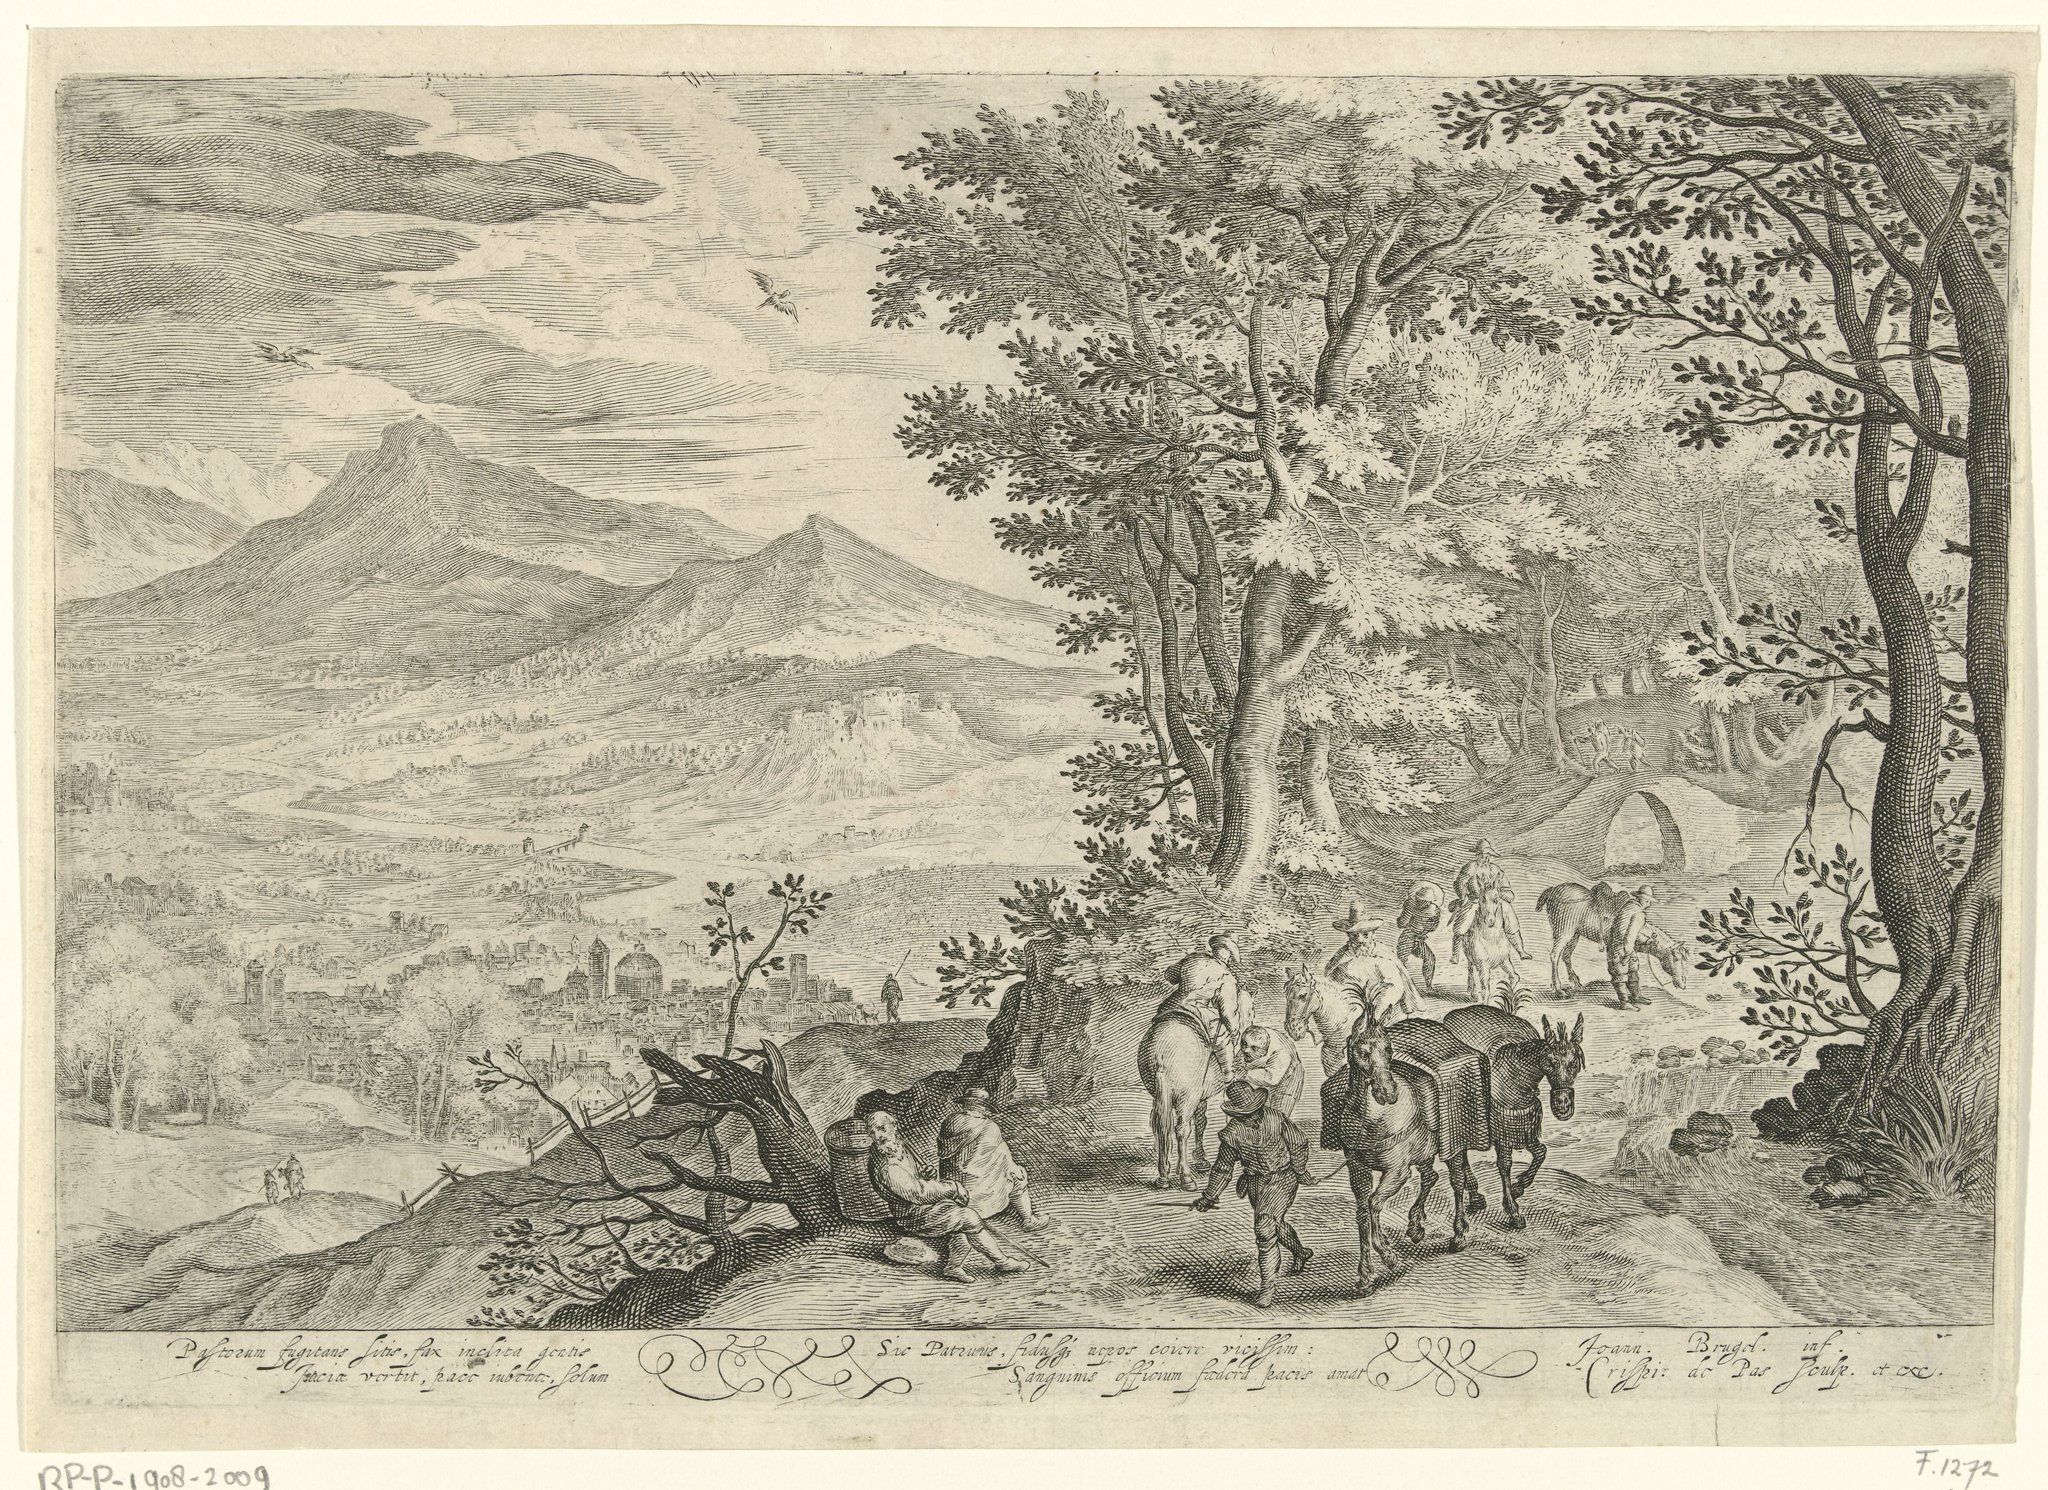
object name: print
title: Boslandschap met reizigers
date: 1588-1589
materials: paper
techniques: engraving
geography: aachen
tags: dale, valley, forest path or lane, 'en route', traveller under way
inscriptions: collector's mark: Lugt 538, collector's mark: Lugt 2228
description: Boslandschap met reizigers en paarden op een pad. Links op de achtergrond een vallei met een stad. In de marge een vierregelig onderschrift, in twee kolommen, in het Latijn.